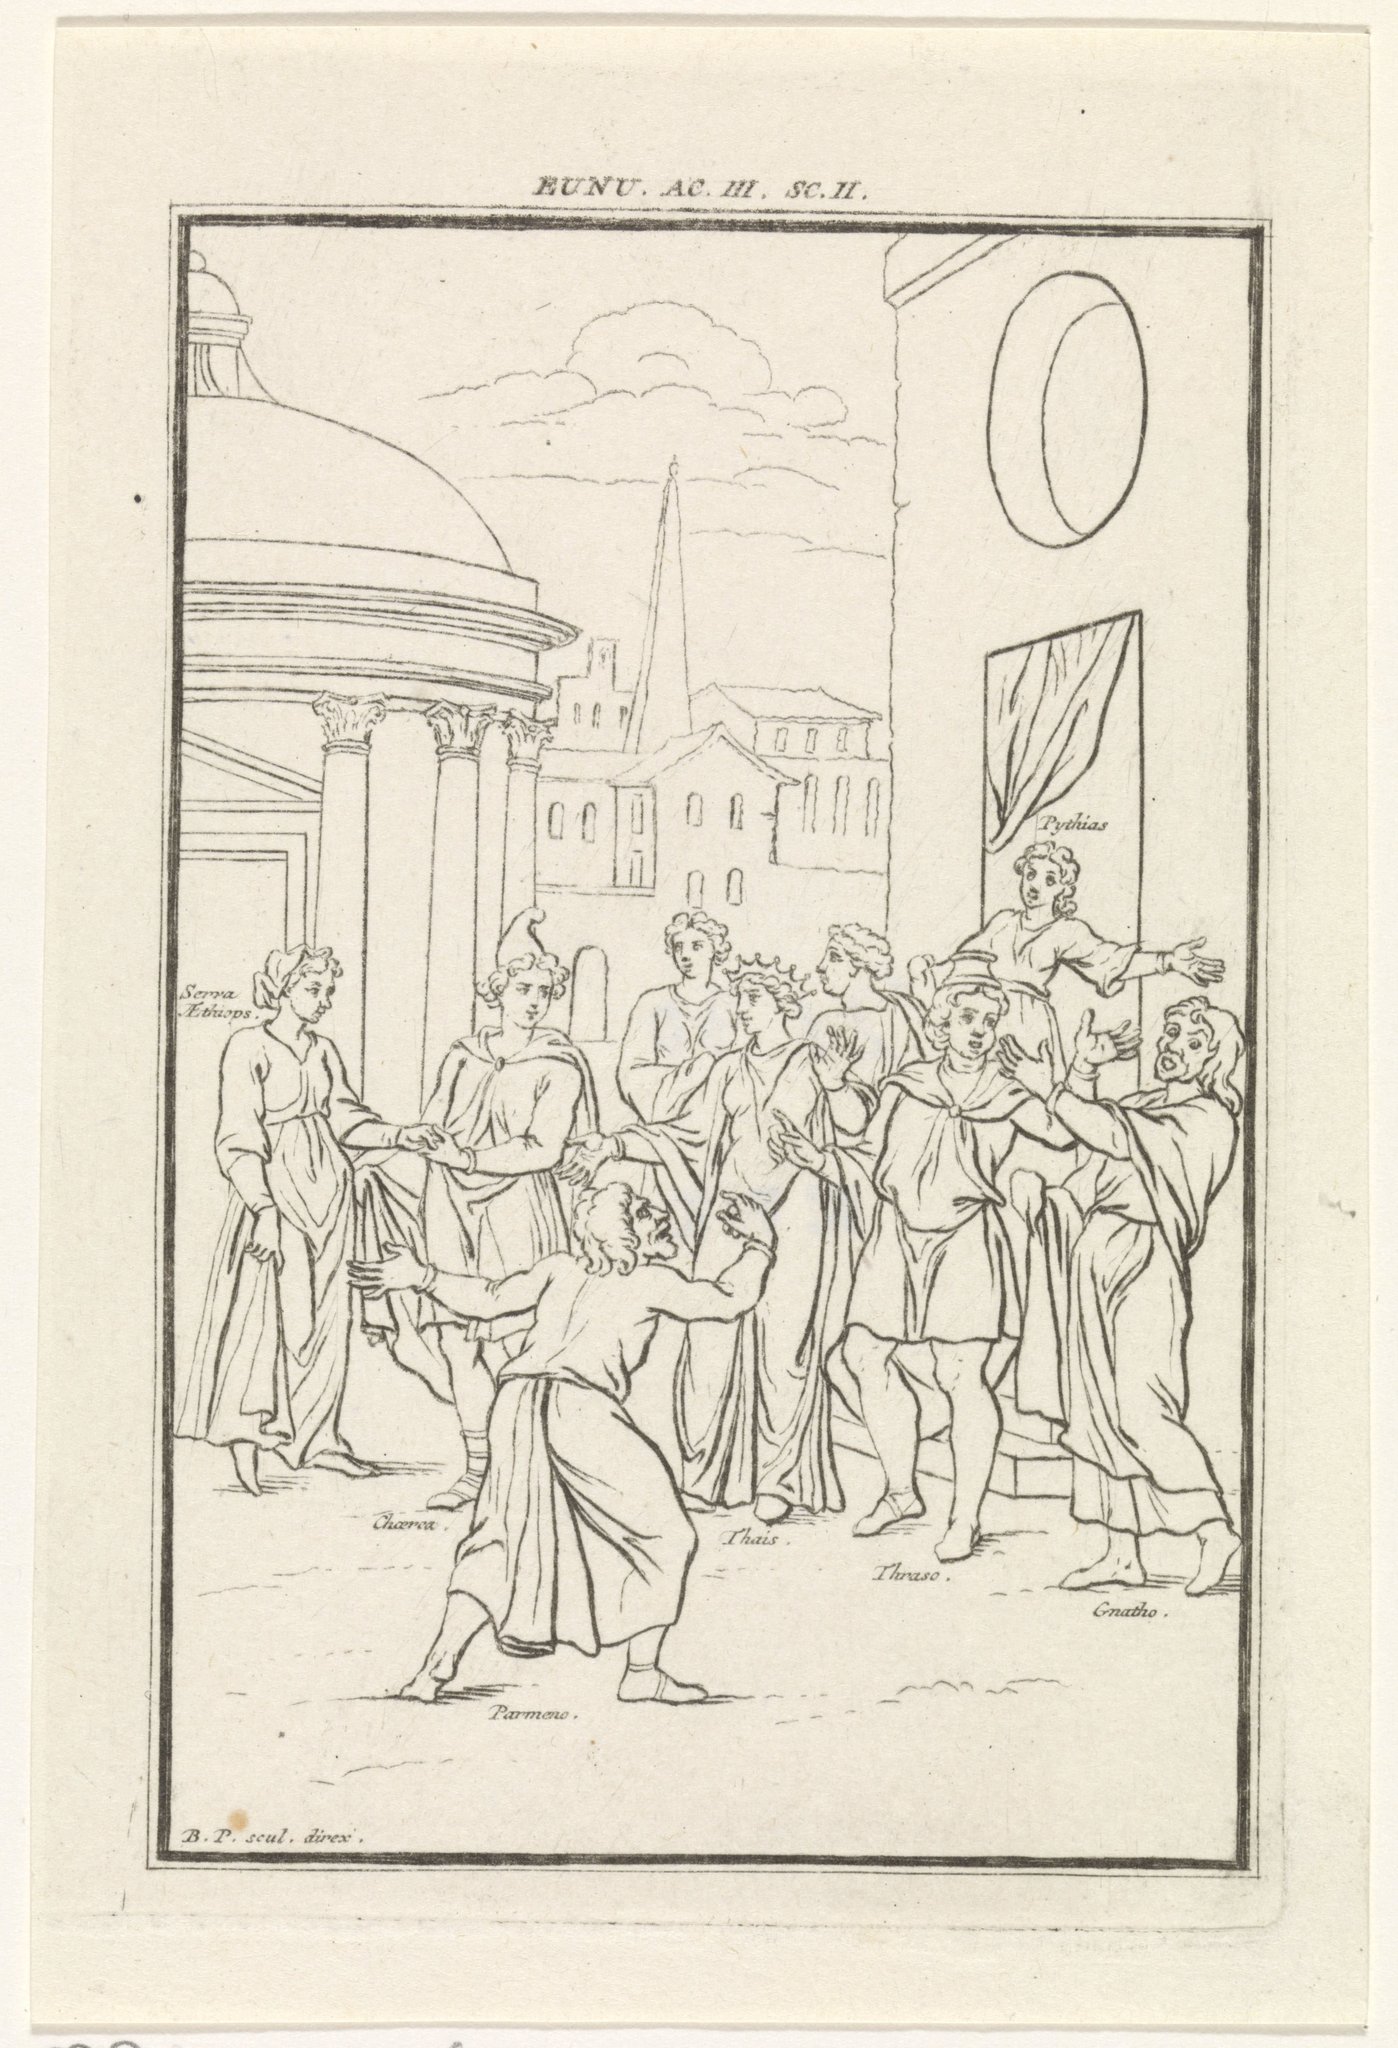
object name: book illustration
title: Scène uit de komedie Eunuchus van Terentius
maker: bernard picart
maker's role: draughtsman, print maker, publisher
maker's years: 1673-1733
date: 1716-1718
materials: paper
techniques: engraving, etching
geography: amsterdam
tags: master ~ enslaved person, slavery; serfs and enslaved persons, specific works of literature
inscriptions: collector's mark: Lugt 2233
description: De courtisane Thais ontvangt een tot slaaf gemaakt meisje uit Athene. De omstanders reageren opgewonden. De slaafgemaakte Parmeno wijst op het meisje. Onder de figuren staat de naam van hun personage. Bovenaan gemerkt: Eunu. Ac. III Sc. II.